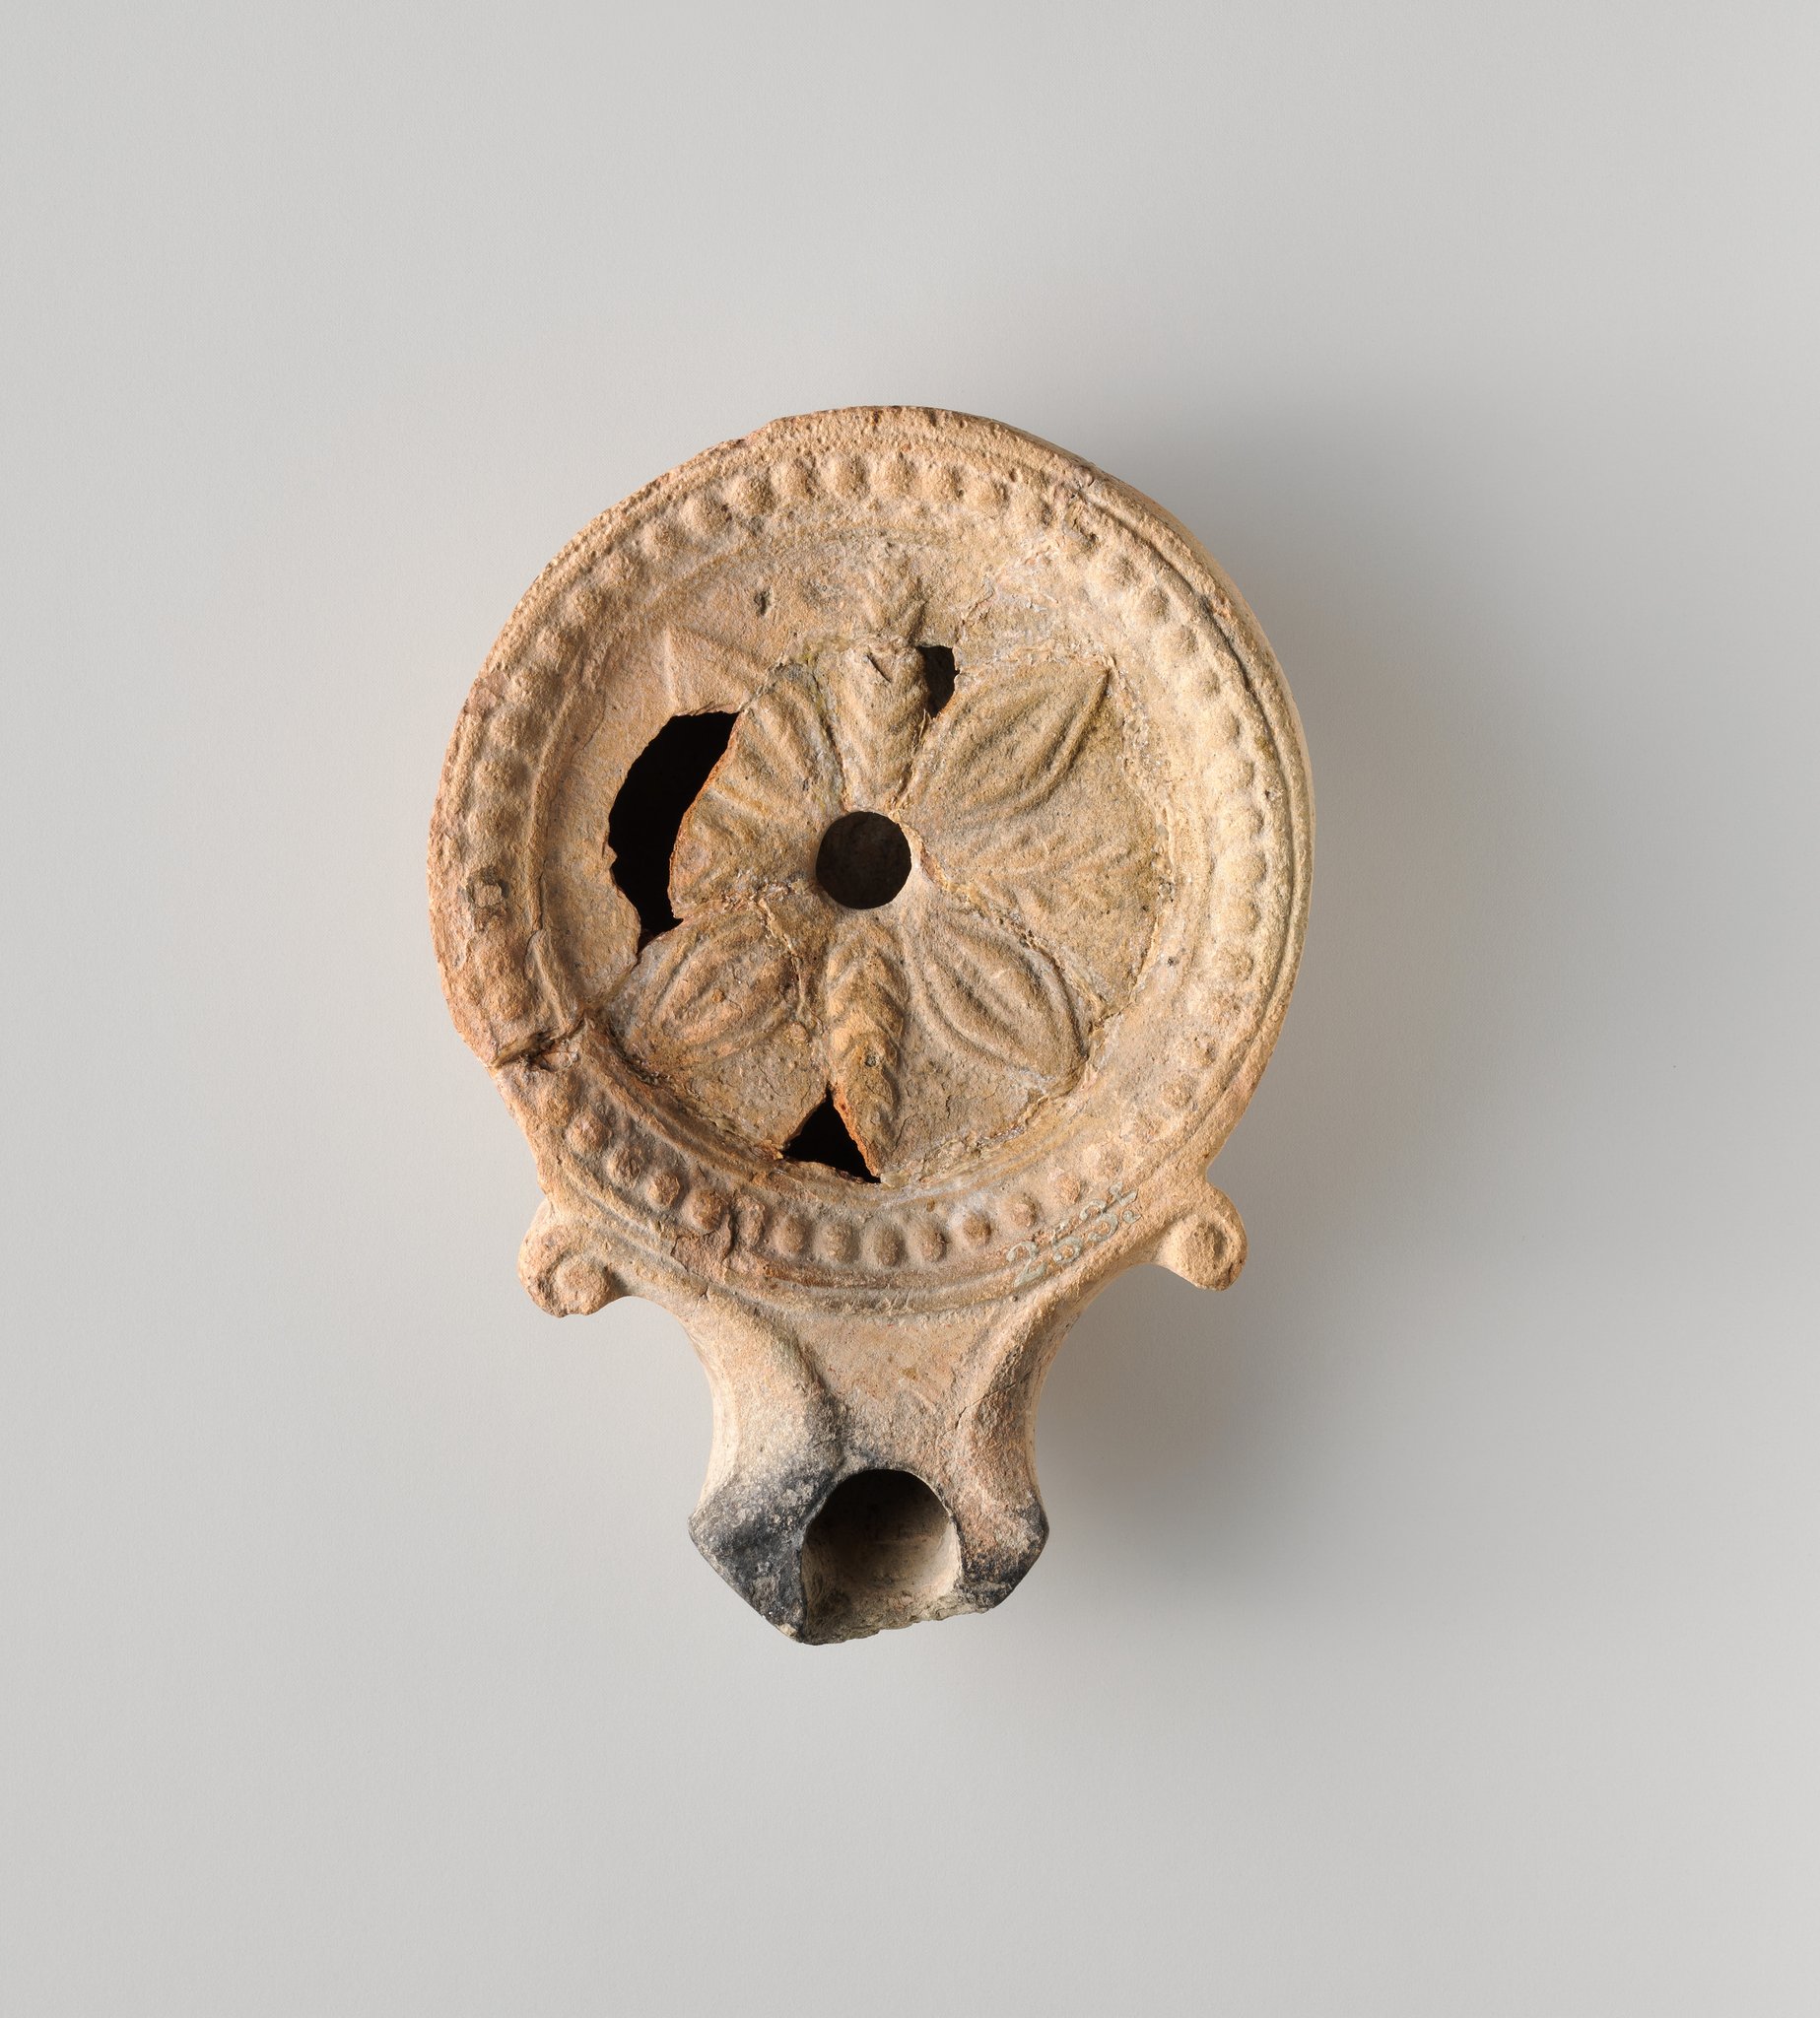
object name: lamp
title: Terracotta oil lamp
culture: roman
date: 100 BCE-100 CE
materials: terracotta